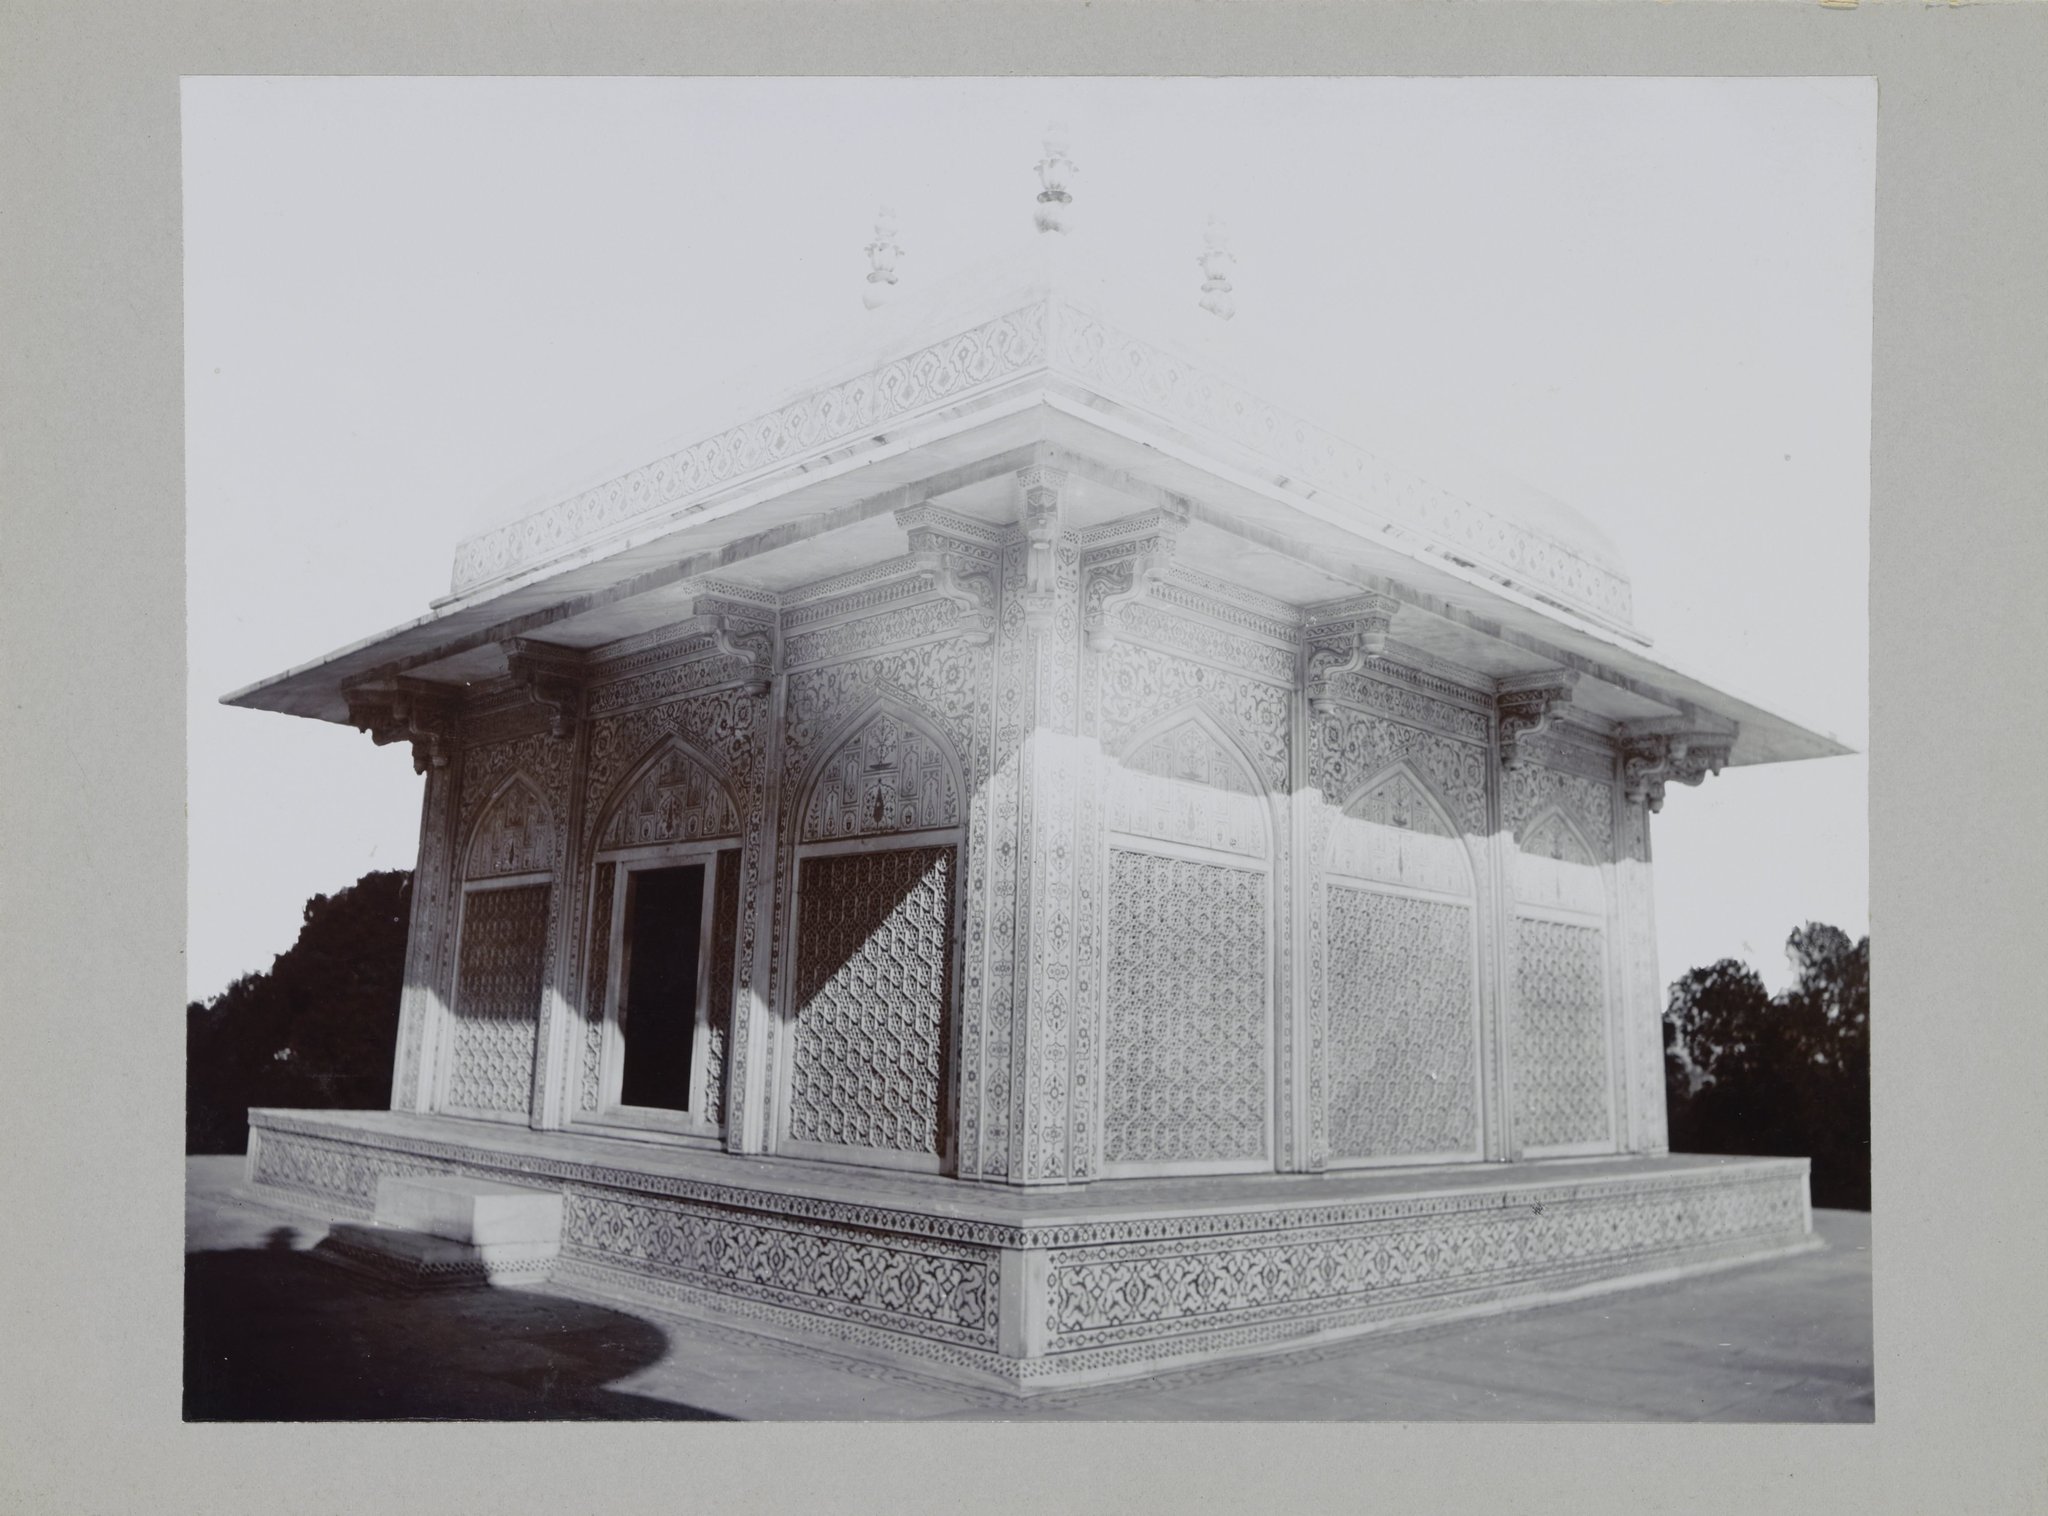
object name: photograph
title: A building inside the Agra Fort, Uttar Pradesh, India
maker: Anonymous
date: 1895-1915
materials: cardboard, paper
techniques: gelatin silver print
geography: agra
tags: agra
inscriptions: annotation: ‘66. Fort te Agra.’